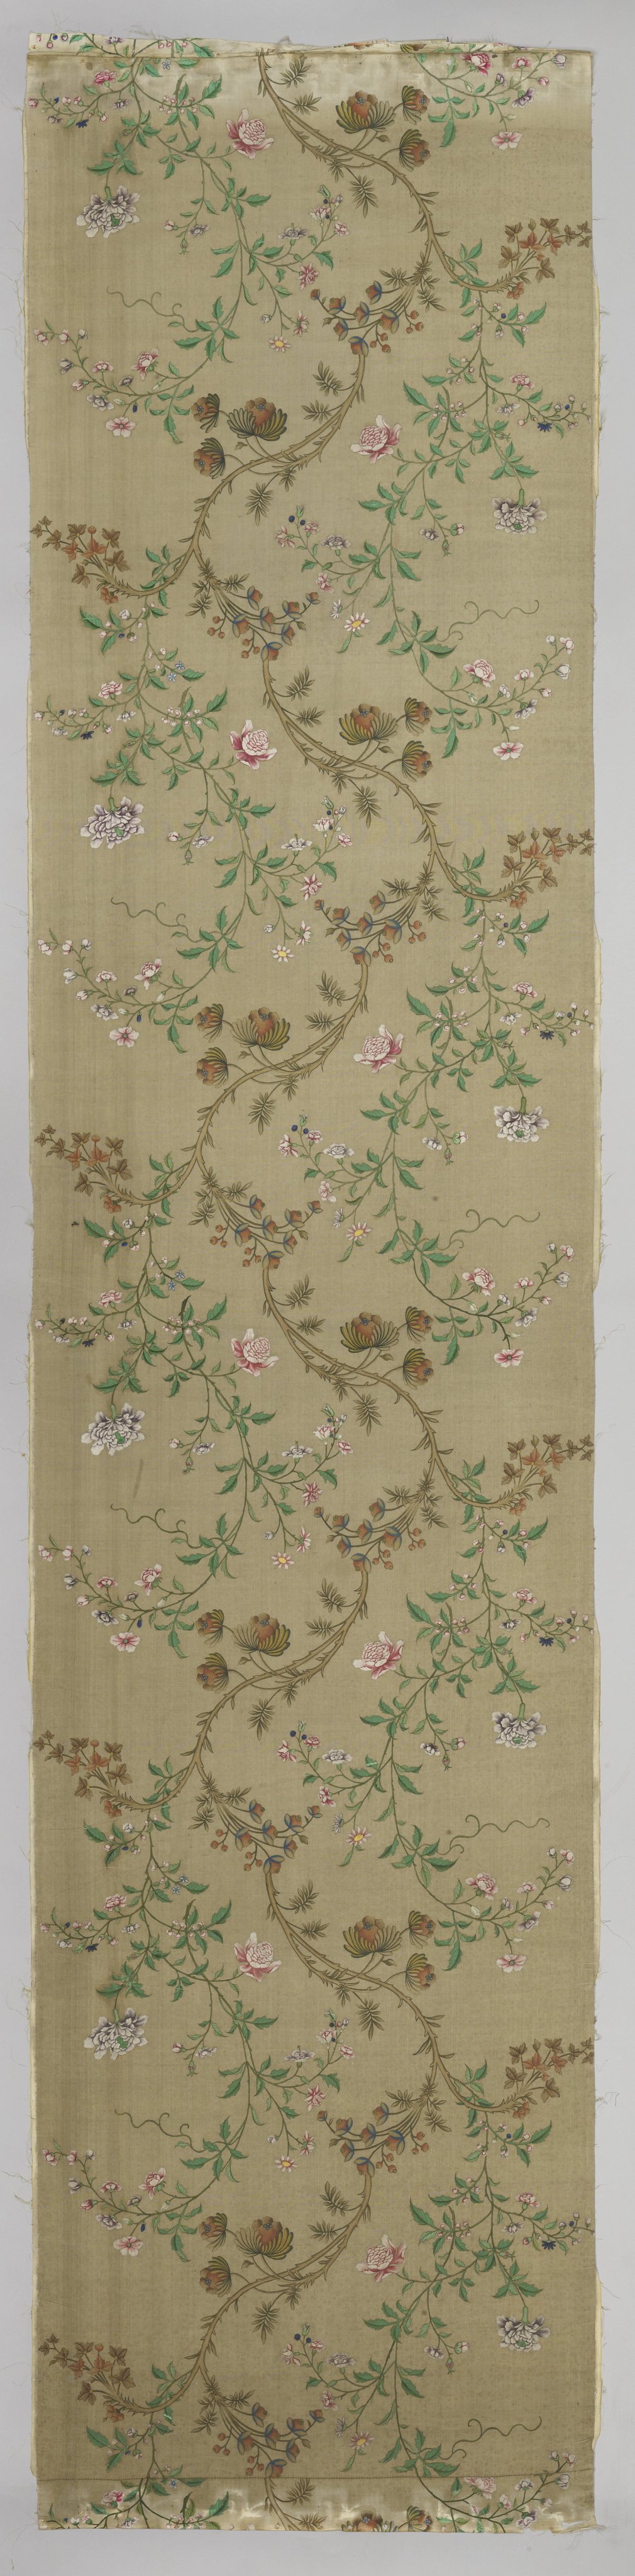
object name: upholstery fabric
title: Bespanningsstof met decor van takken, bladeren, bloemen en vruchten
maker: Anonymous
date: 1750-1790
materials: paint, silk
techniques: printing, weave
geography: china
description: Een baan veelkleurig beschilderde creme bespanningsstof van zijde. Beschrijving zie A.